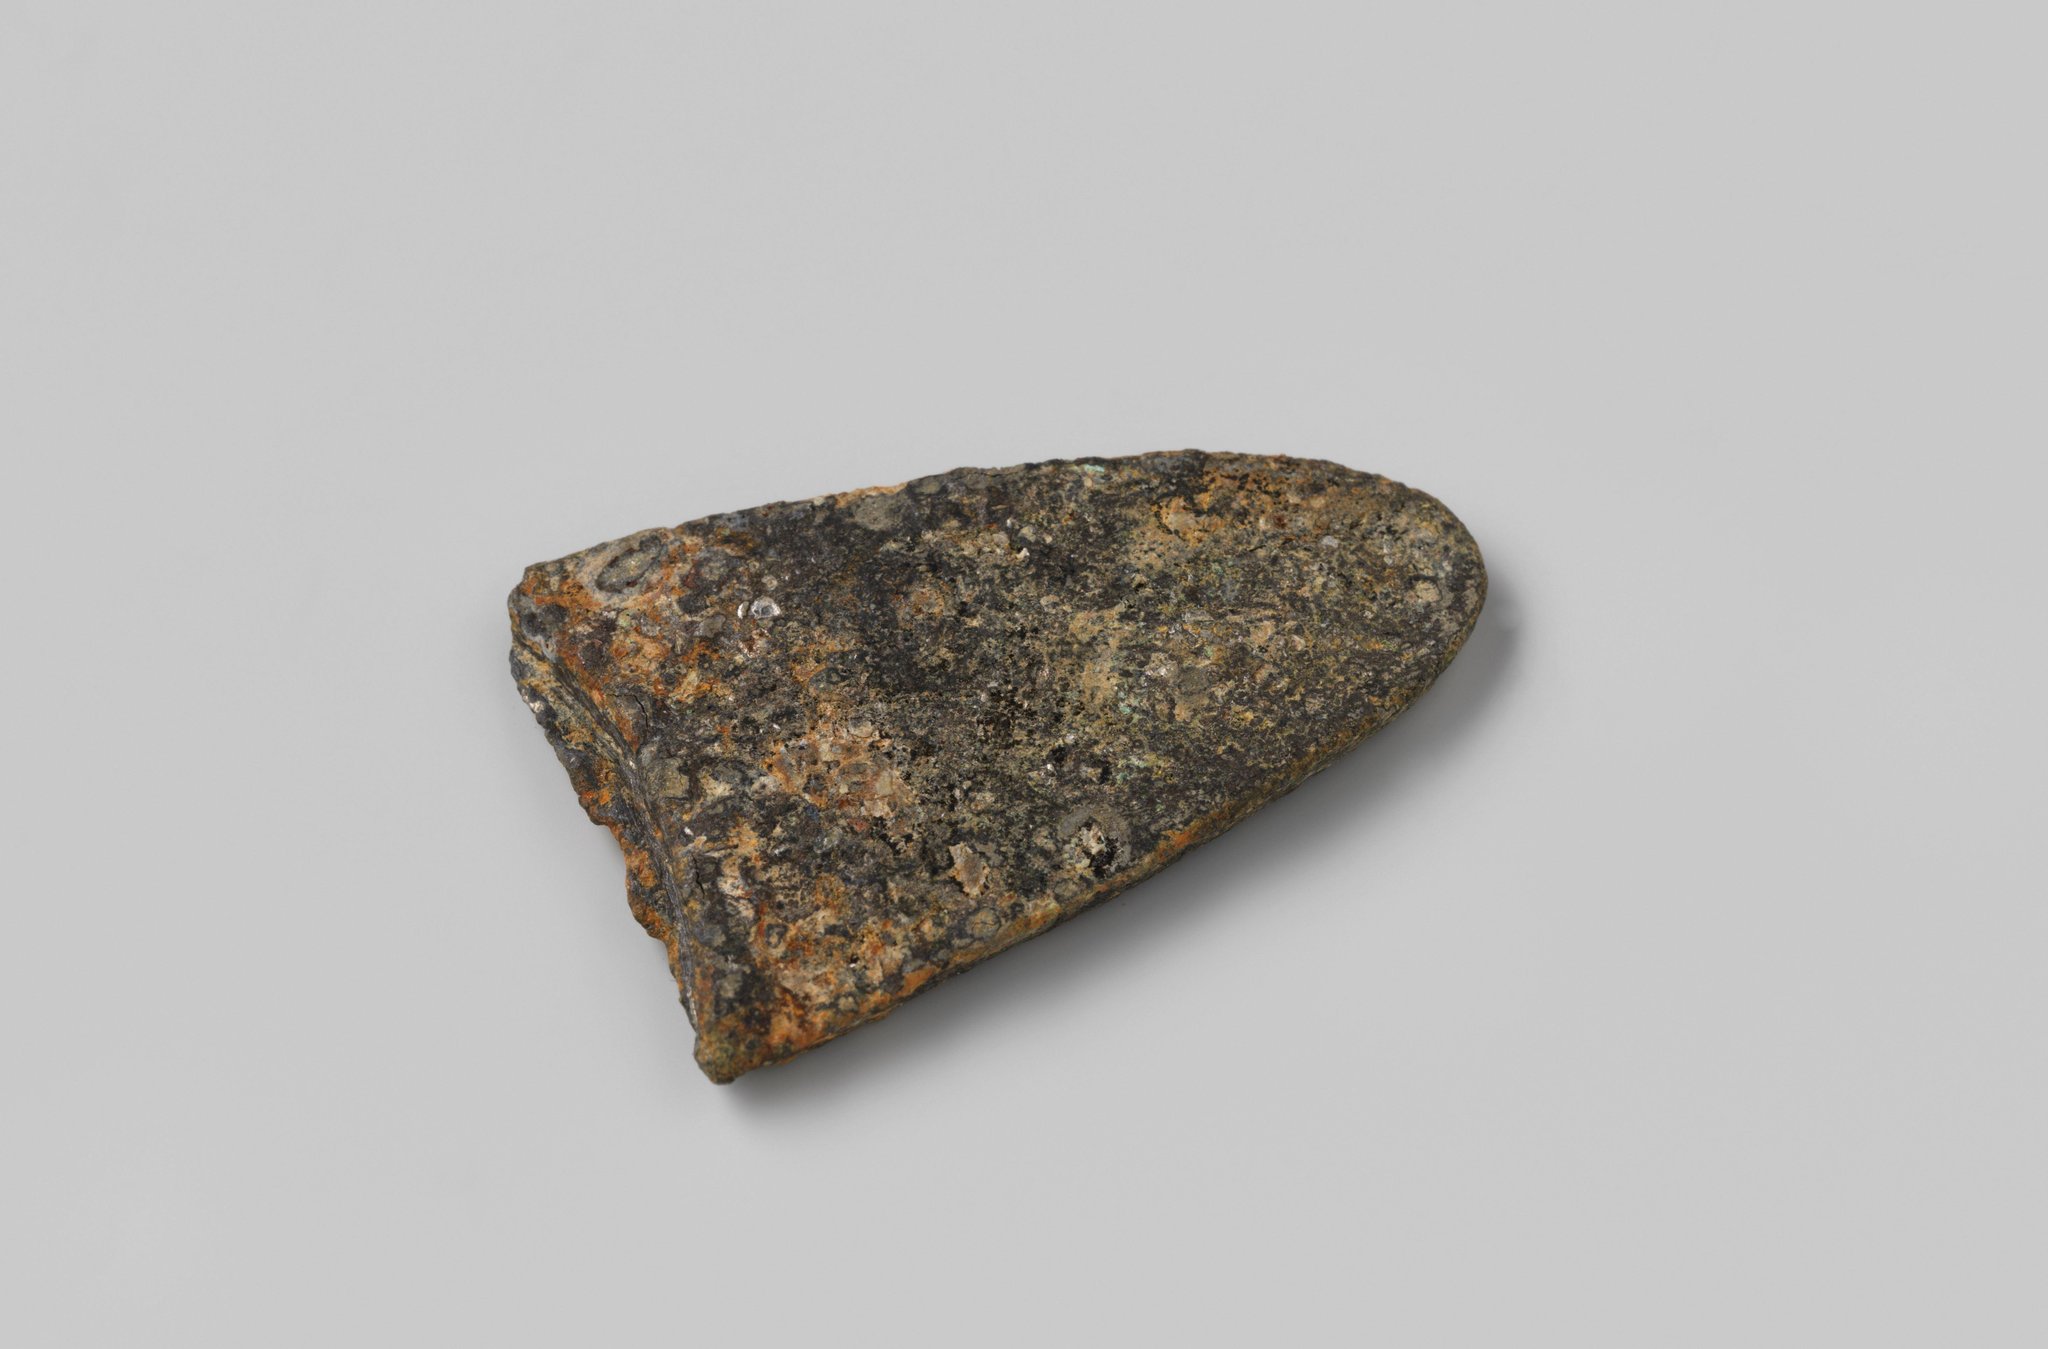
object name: fragment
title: Fragment van tin uit het wrak van de Oost-Indiëvaarder Hollandia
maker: Anonymous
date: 1700-1743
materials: tin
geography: netherlands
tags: verenigde oostindische compagnie, hollandia (schip), annet